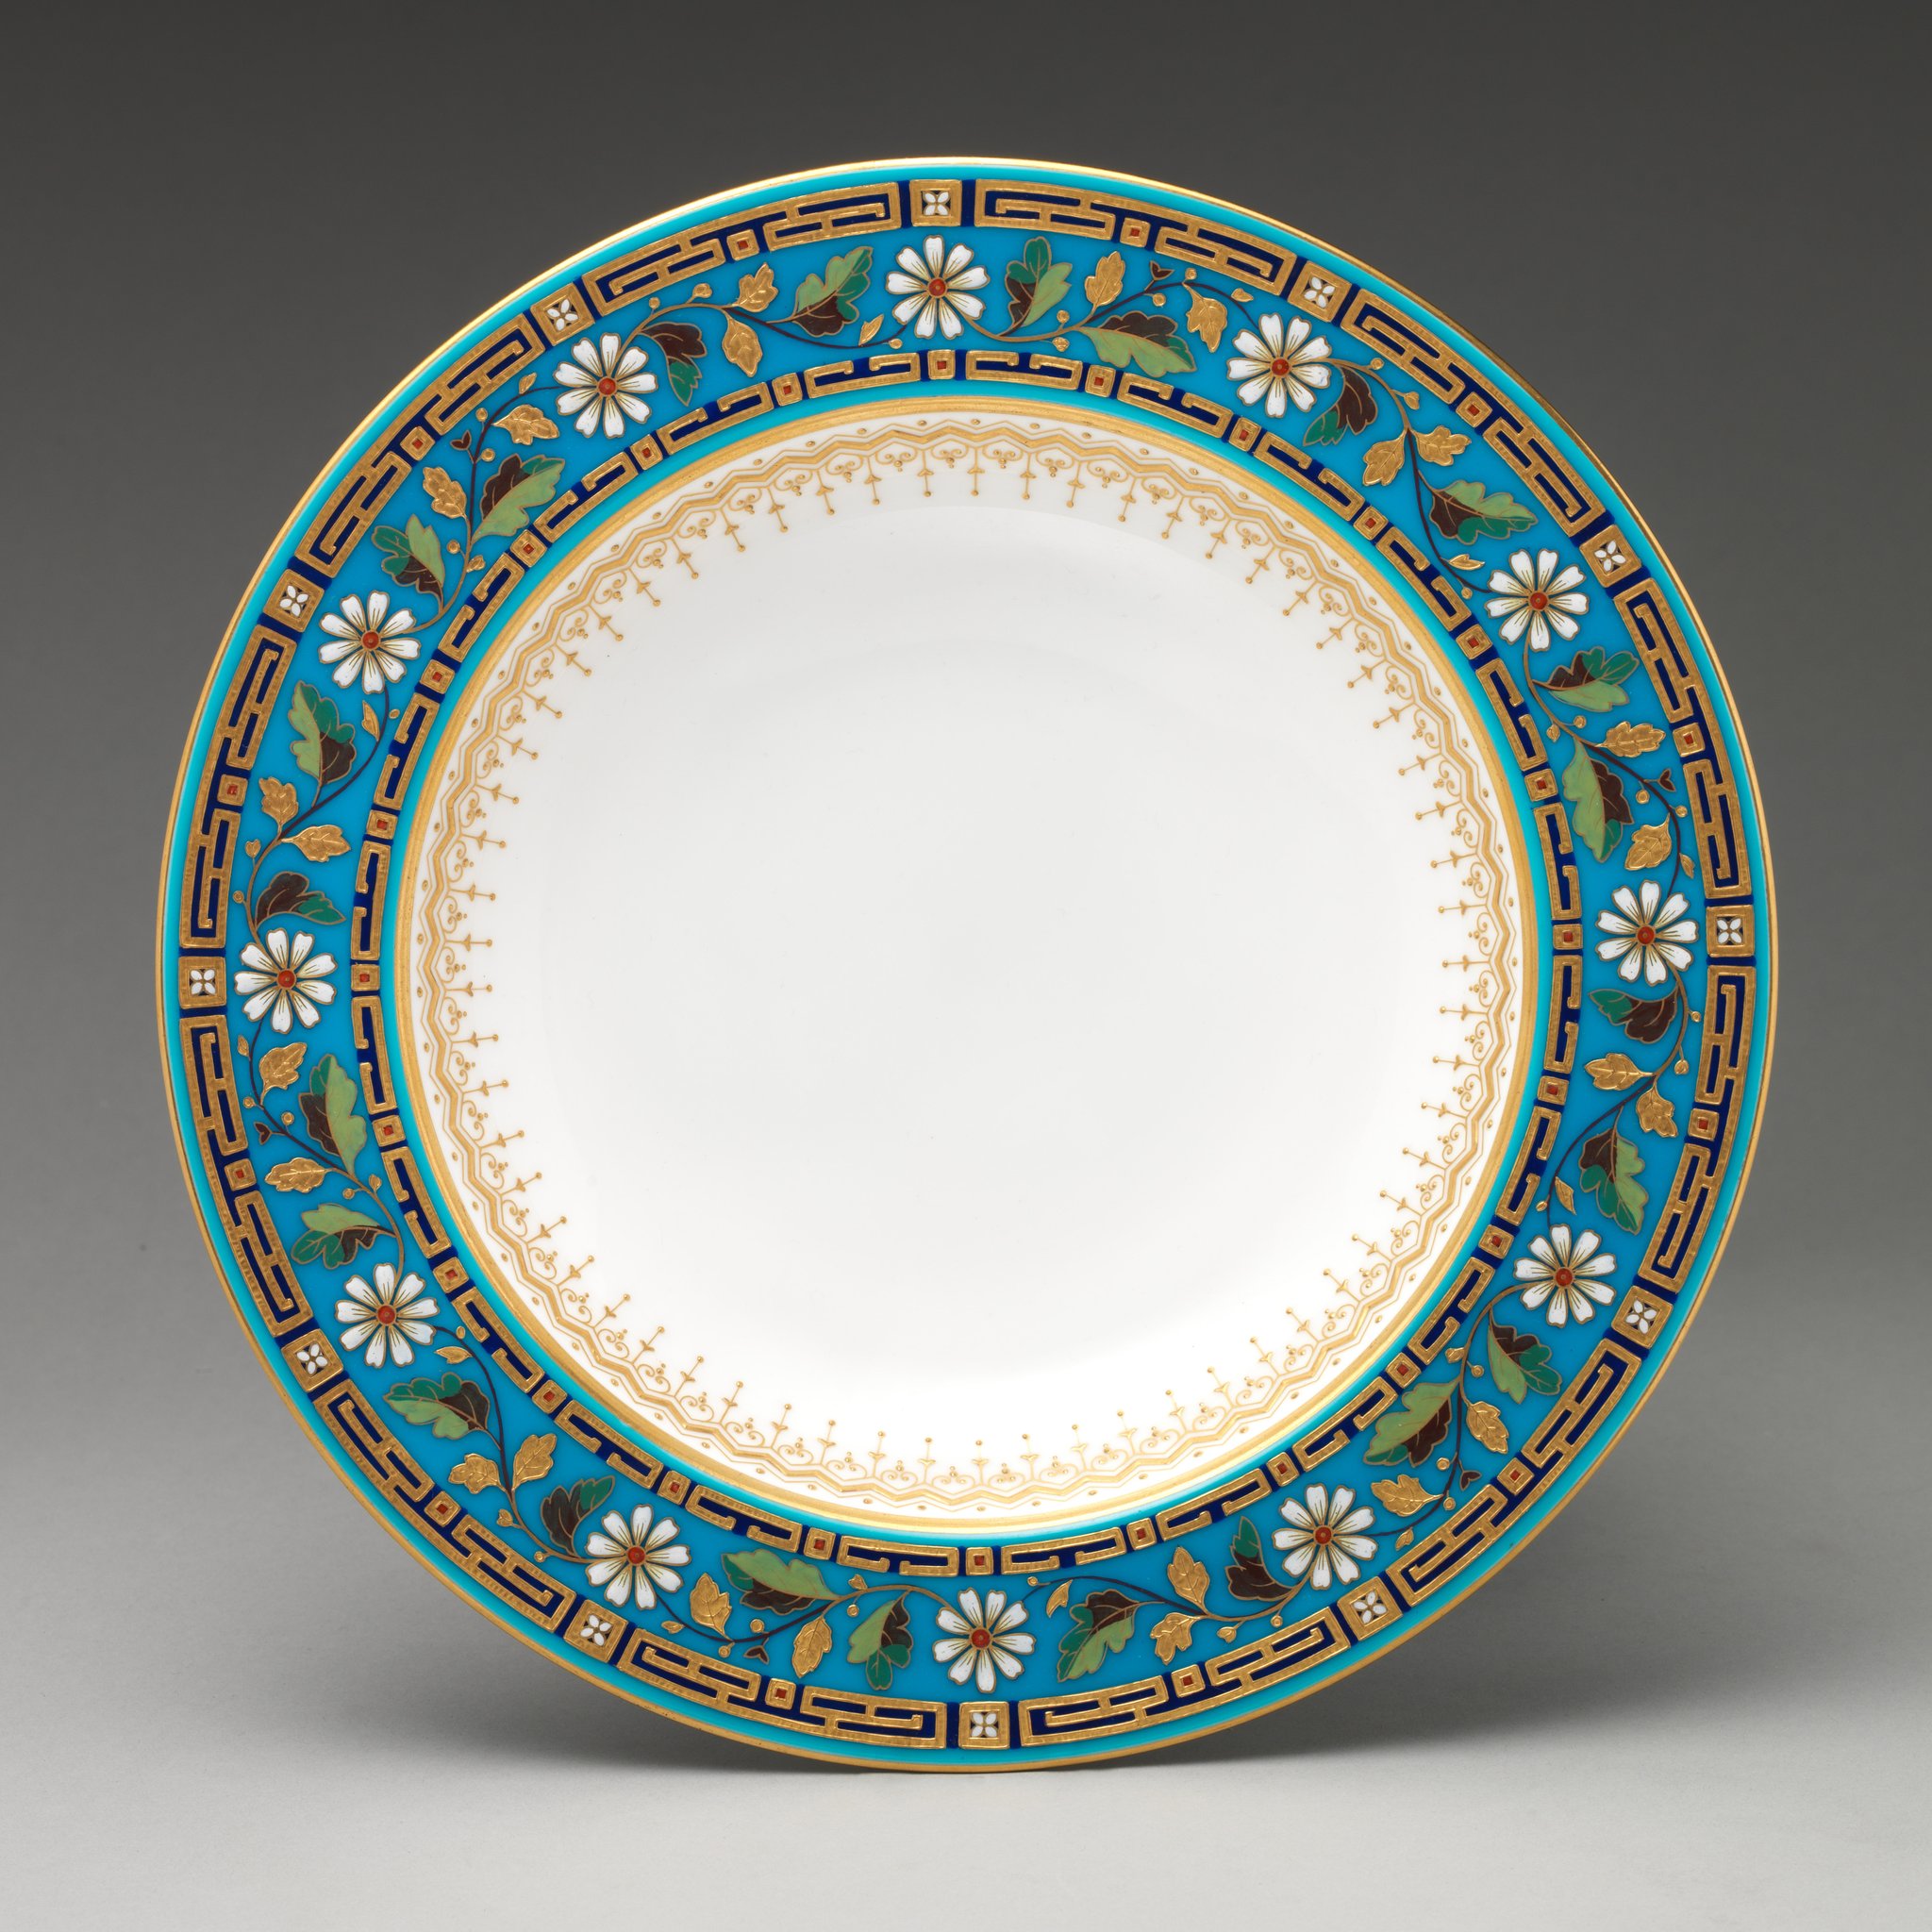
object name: soup plate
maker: minton(s)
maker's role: factory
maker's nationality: british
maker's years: 1793-2001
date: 1880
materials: bone china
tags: flowers